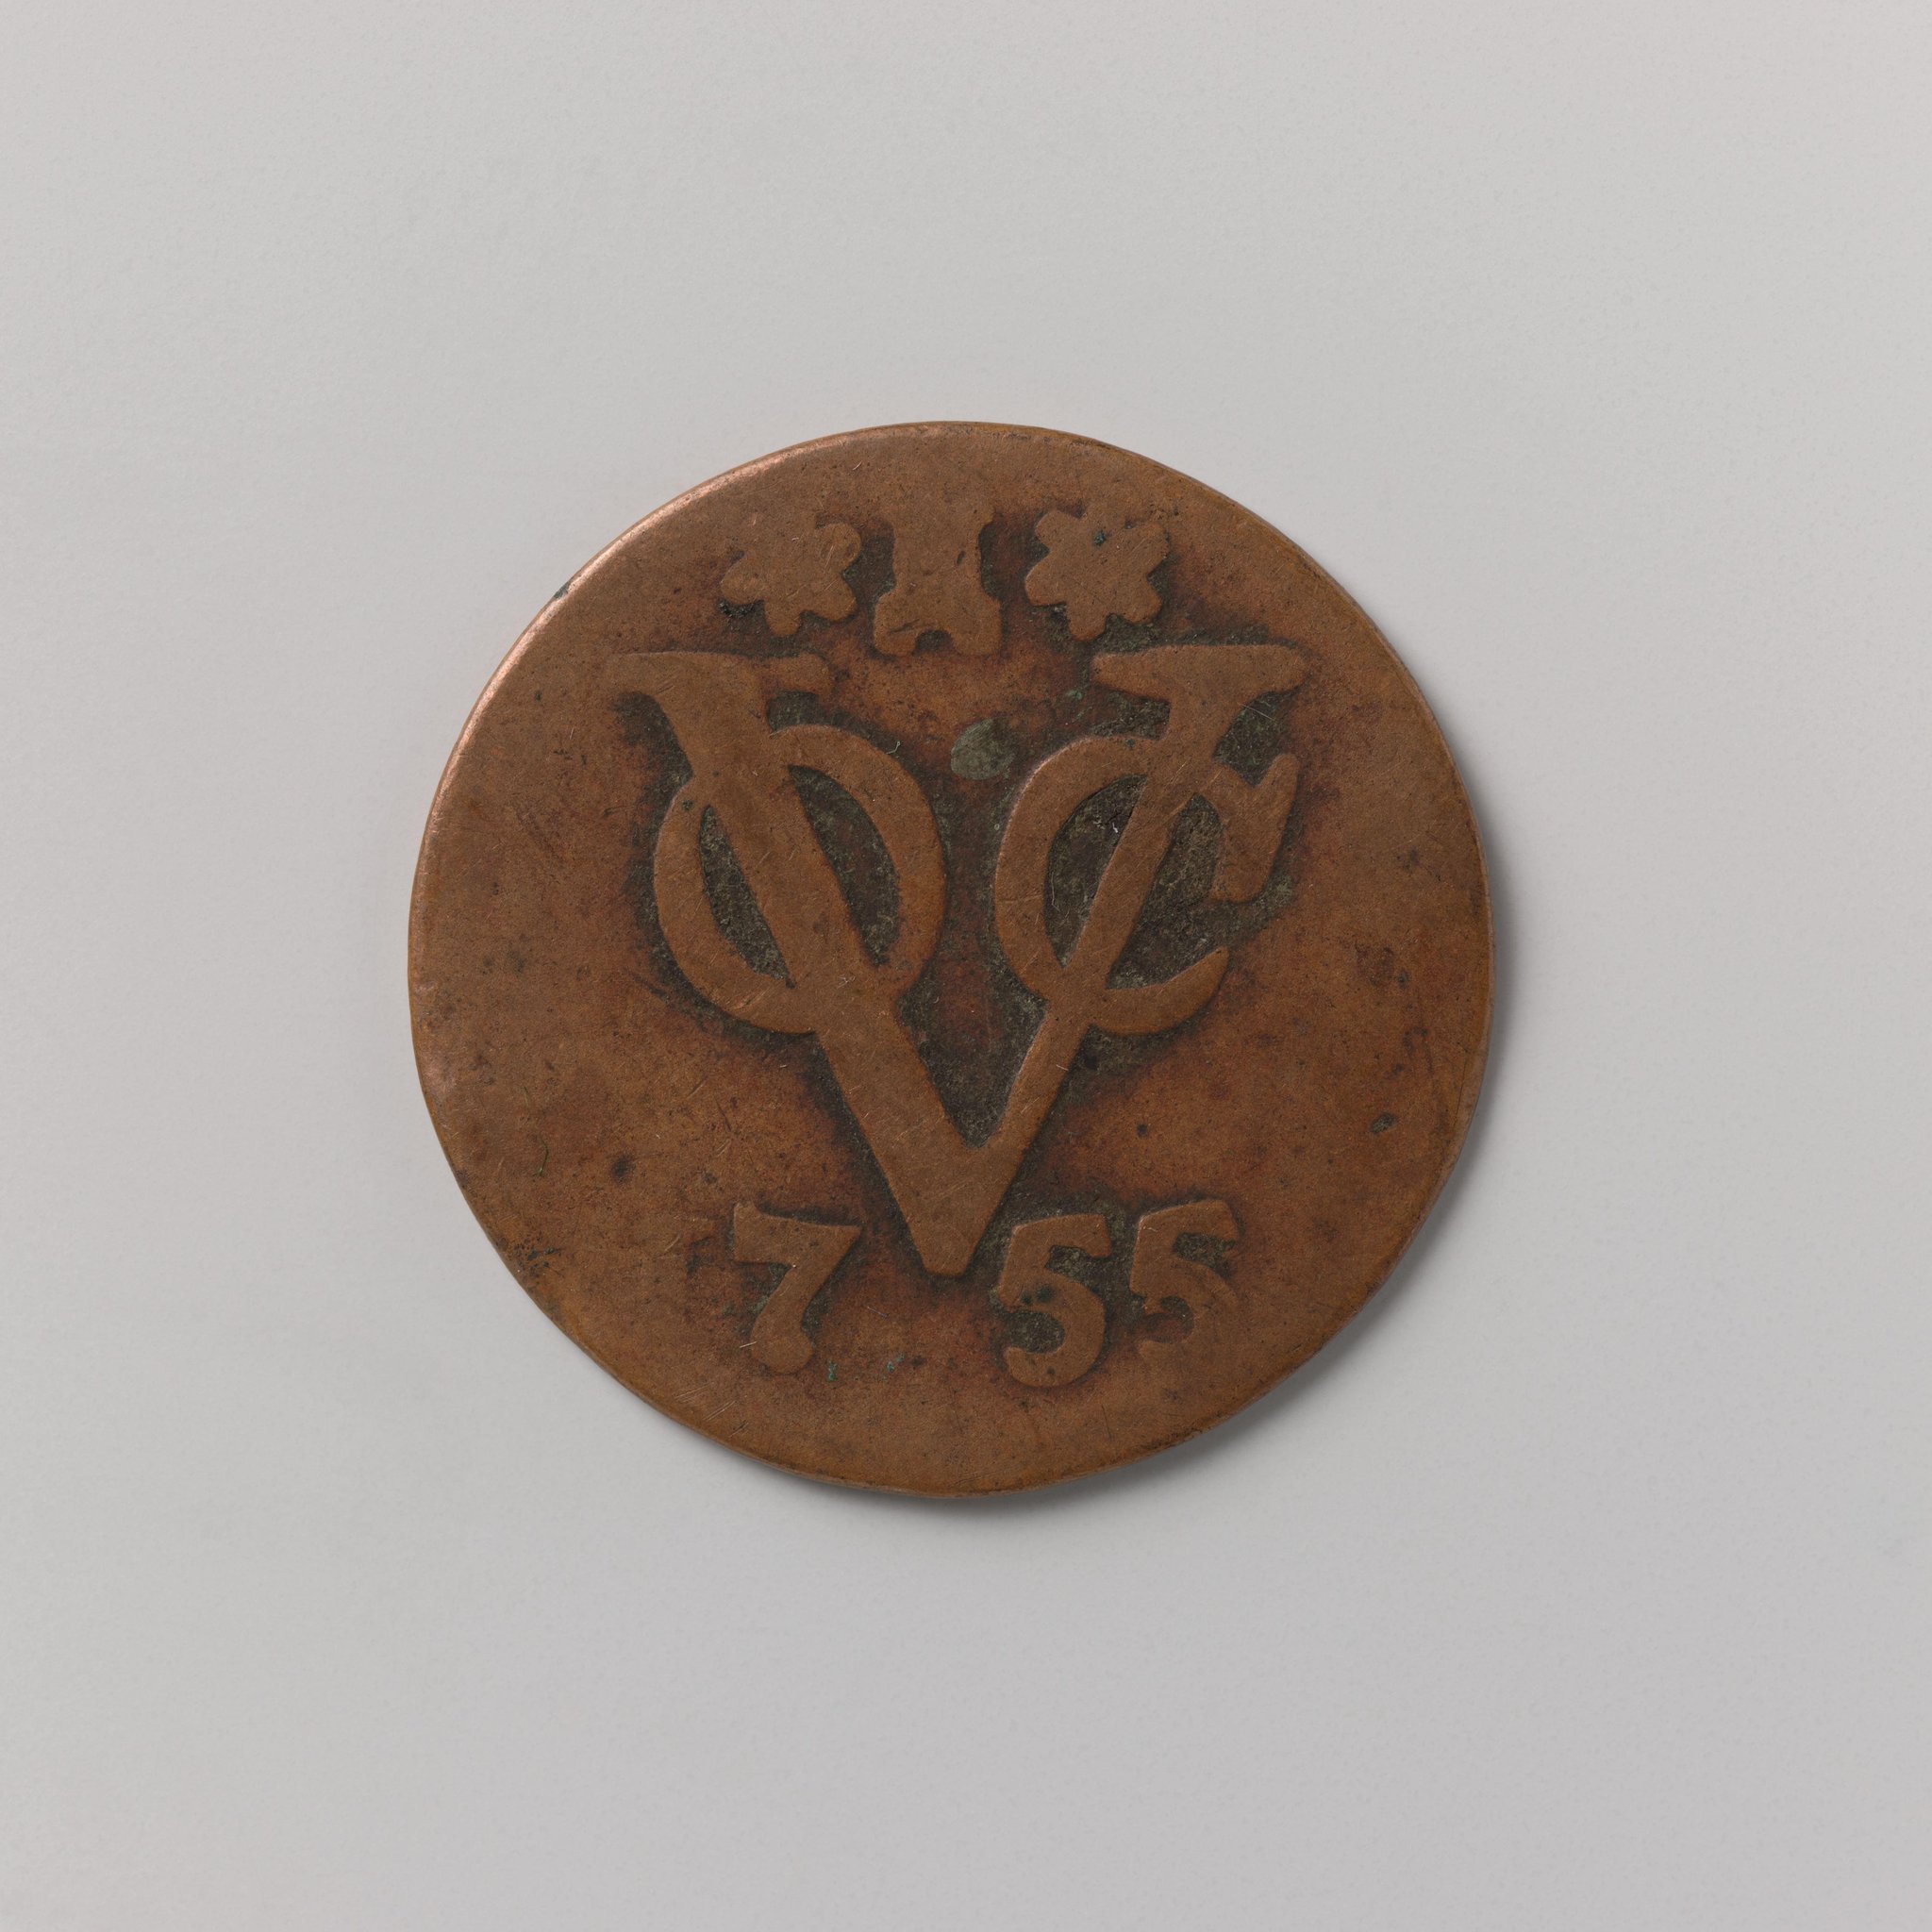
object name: coin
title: Duit van de VOC uit Zeeland, 1755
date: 1755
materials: copper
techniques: striking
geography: middelburg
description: Koperen munt. Voorzijde: gekroond wapenschild van Zeeland. Keerzijde: monogram van de VOC, waarboven muntteken en waaronder jaartal. Gladde rand.